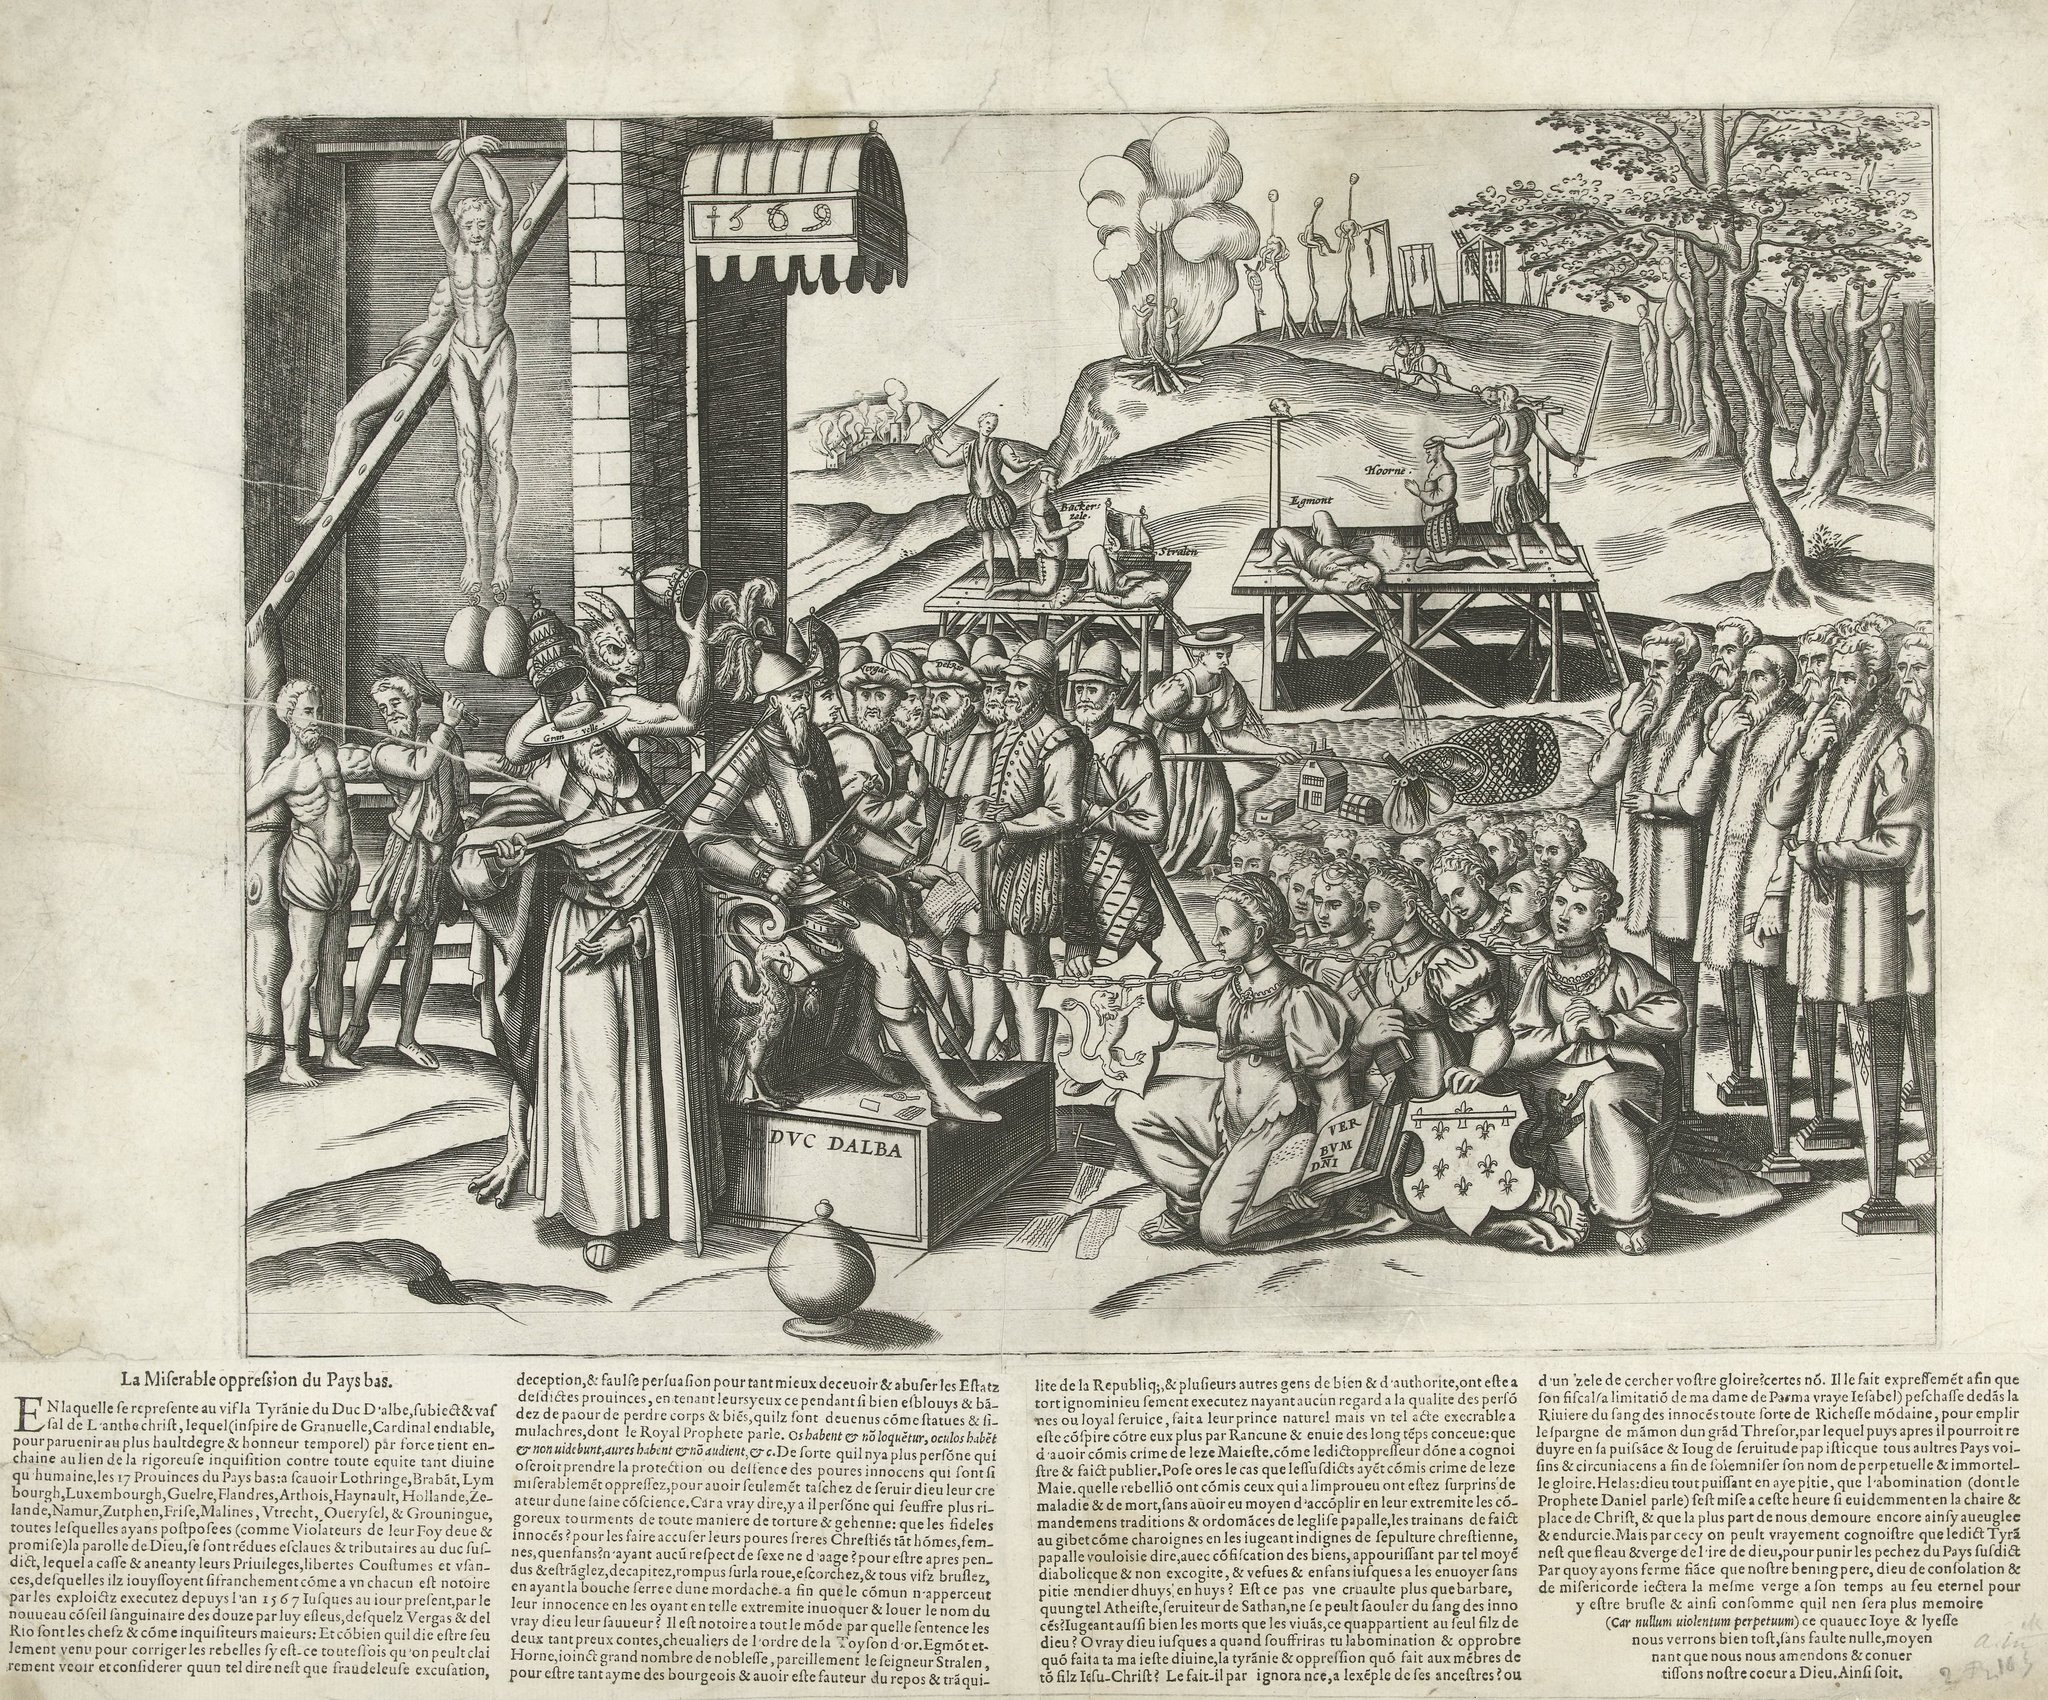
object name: print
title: The Tragic Oppression of the Netherlands, 1569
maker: Anonymous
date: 1569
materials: paper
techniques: engraving, letterpress printing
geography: southern netherlands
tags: fernando álvarez de toledo (3rd duke of alba), antoine perrenot de granvelle, bruges, on the scaffold or place of execution, violent death by beheading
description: Allegorie op de tirannie van de hertog van Alva in de Nederlanden, 1569. Links zit de hertog van Alva op zijn troon met Granvelle (met blaasbalg) en de duivel, achter de hertog staan leden van de Bloedraad, waaronder Vargas en Del Rio. Voor Alva knielen geketend de 17 personificaties van de provincies van de Nederlanden, rechts de verstomde leden van de Staten-Generaal. Hierboven vist Margaretha van Parma naar rijkdommen in een bloedvijver, daarachter de onthoofding van Egmond en Horne en anderen te Brussel in 1568. Op de achtergrond terechtstellingen, links scènes van martelingen. Met onderschrift van vier kolommen in het Frans.